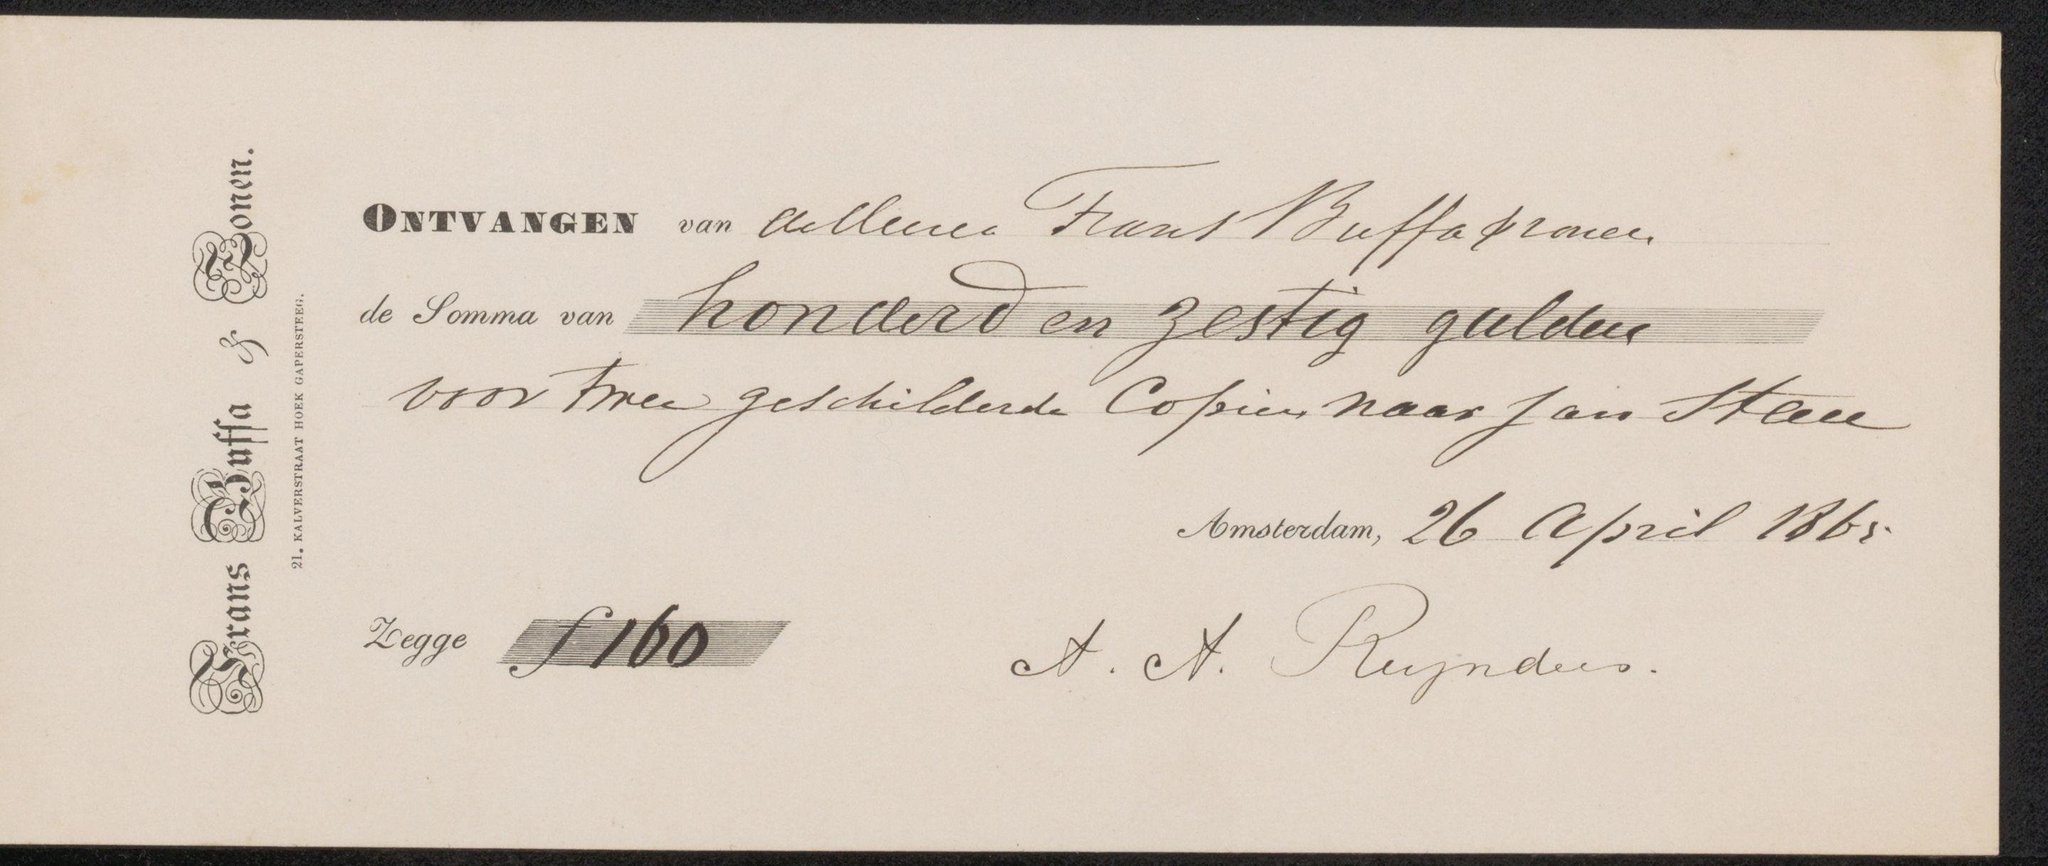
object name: ontvangstbewijs, kwitantie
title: Kwitantie voor Anne Reijnders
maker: anne reijnders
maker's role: draughtsman, painter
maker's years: 1831-1911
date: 1865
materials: ink, paper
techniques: pen, printing, writing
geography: amsterdam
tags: leiden, painter, print maker, jan havicksz. steen, painting (including book-illumination, miniature-painting), money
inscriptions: collector's mark: Lugt 2233